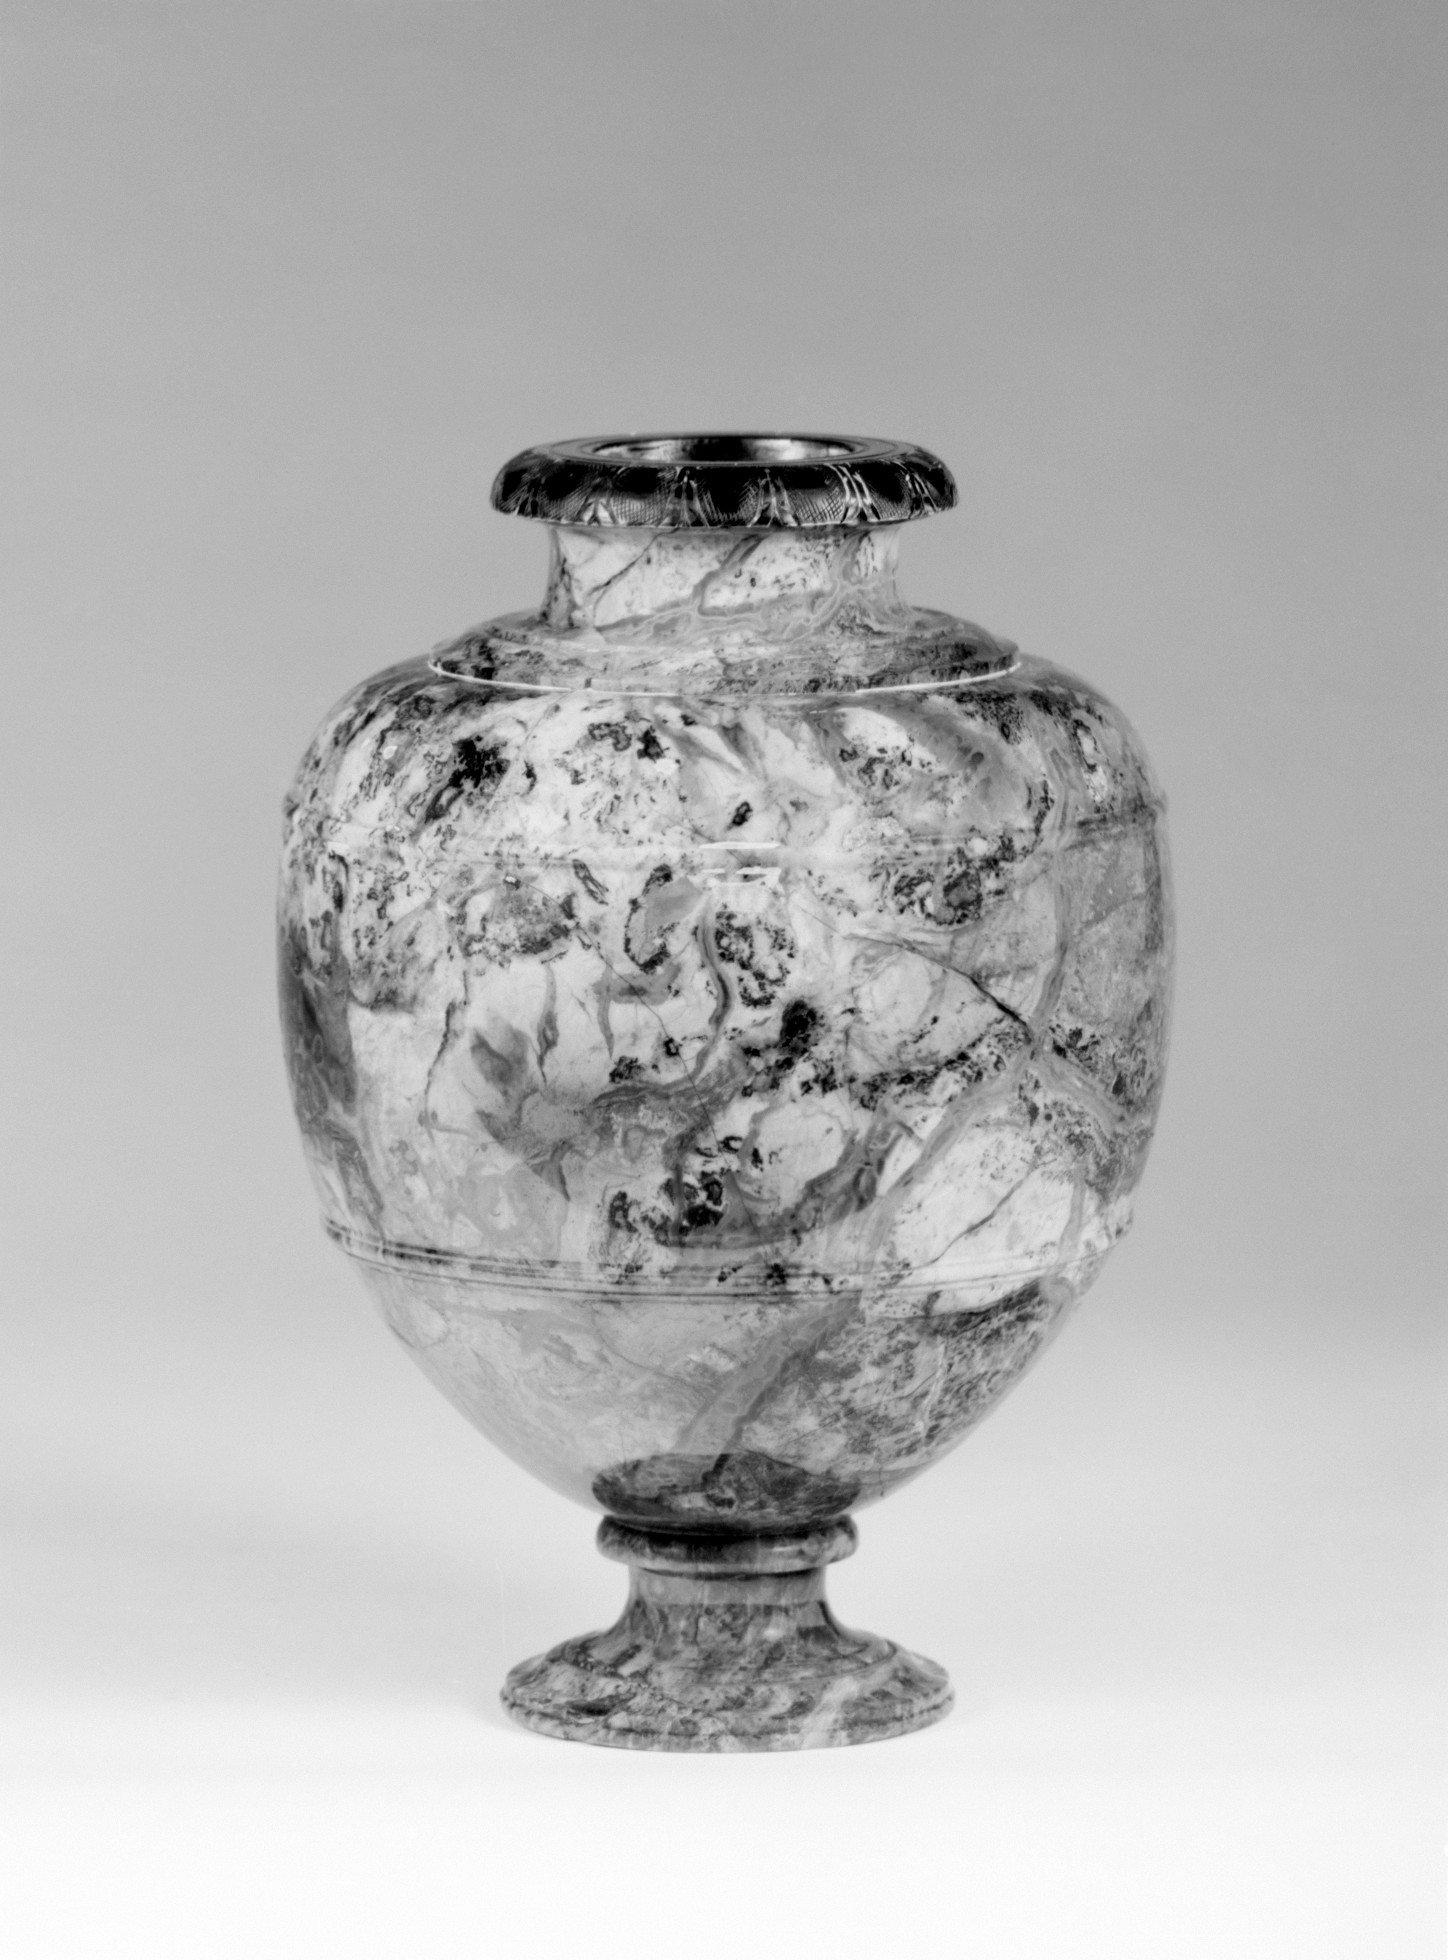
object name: vase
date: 1634-1666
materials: jasper, silver gilt